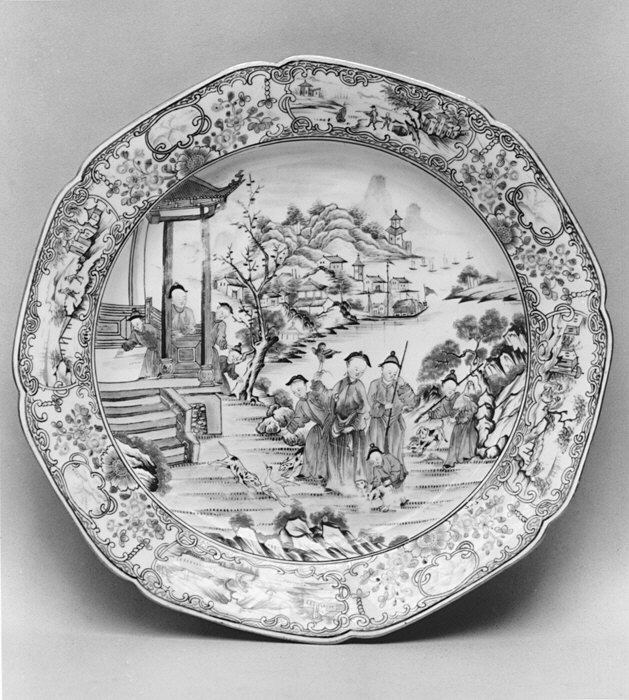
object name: plate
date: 1750-1760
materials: soft paste porcelain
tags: human figures,cranes,chinoiserie,dogs